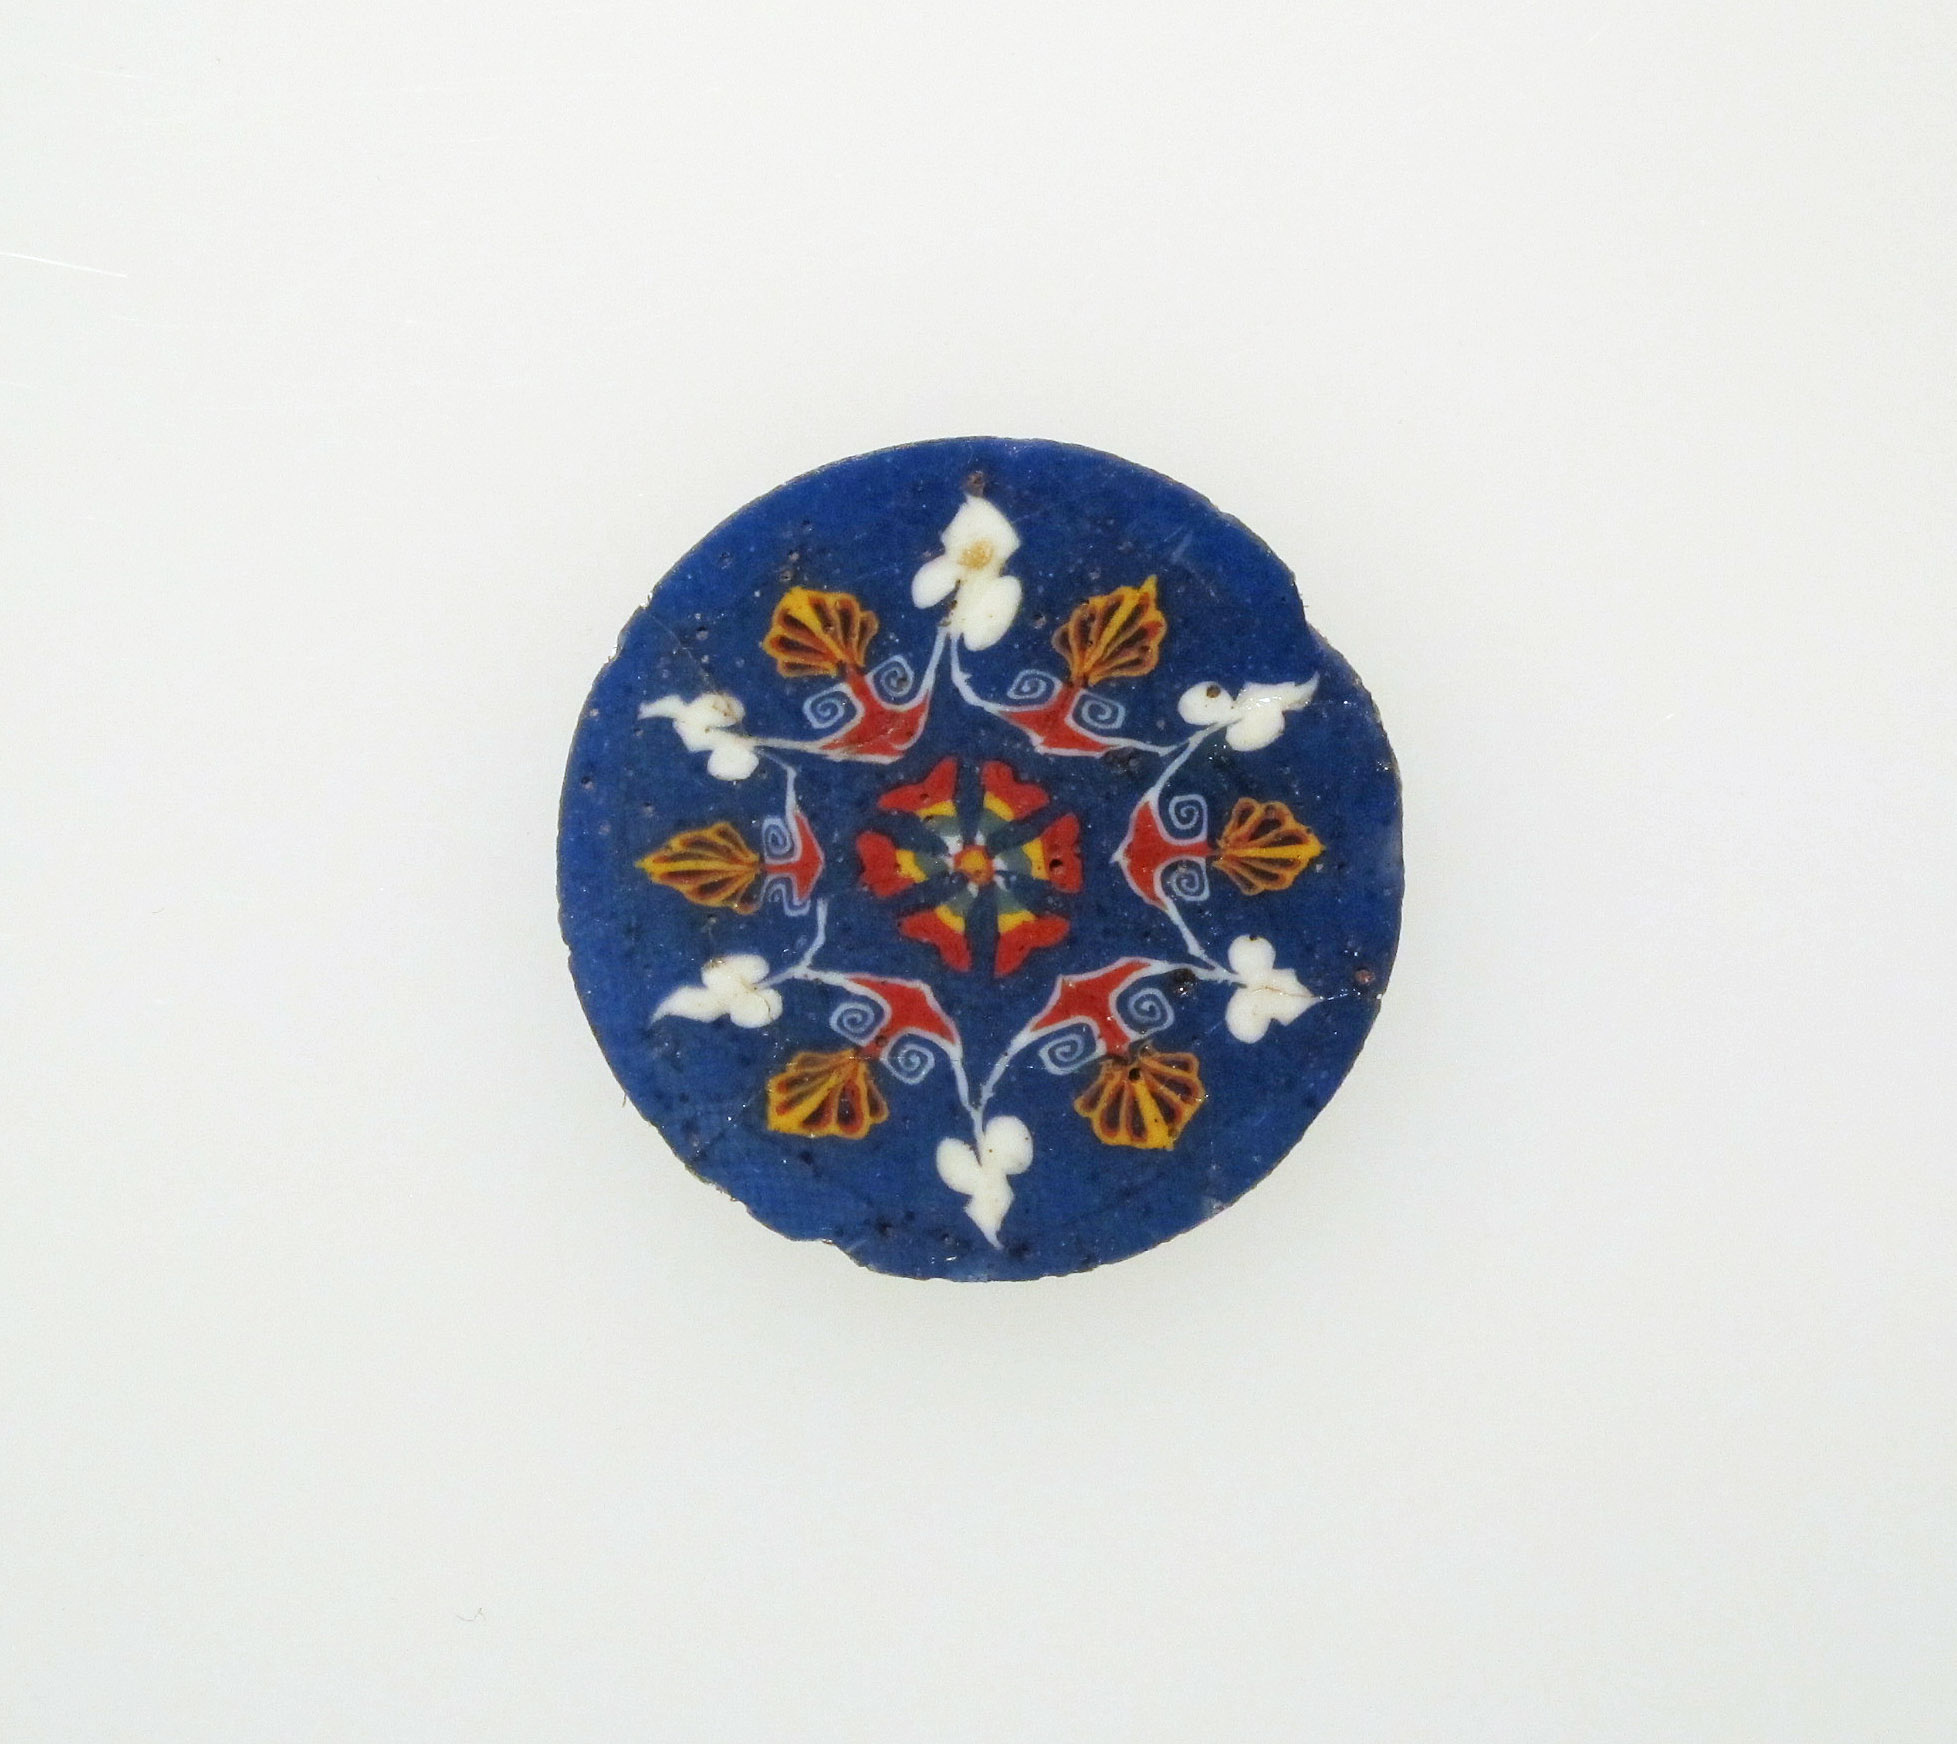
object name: mosaic block inlay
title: Glass mosaic inlay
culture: roman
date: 34 BCE-100 CE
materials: glass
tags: palmettes,lilies